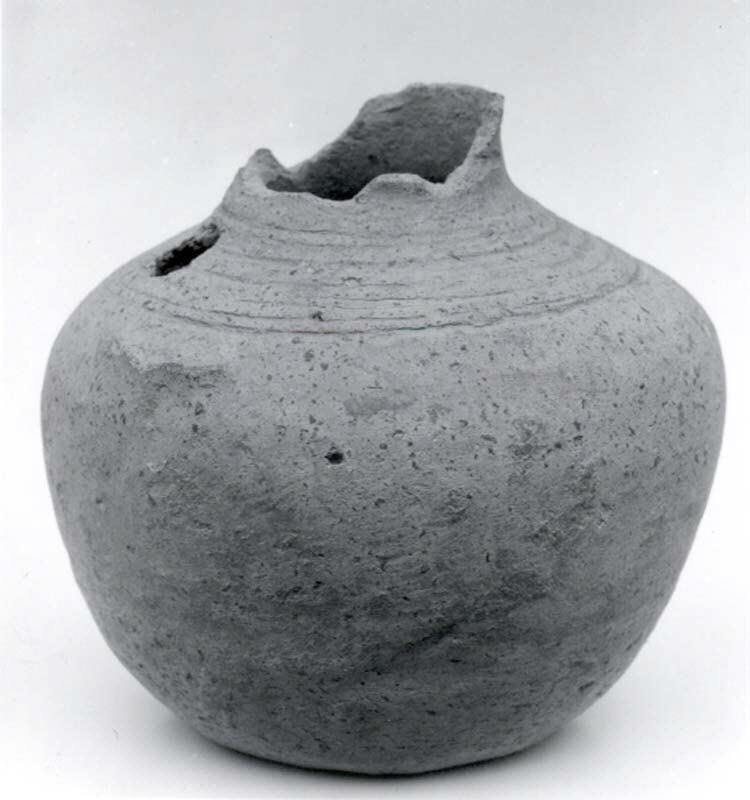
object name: jug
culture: sasanian or islamic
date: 601-900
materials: ceramic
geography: iran